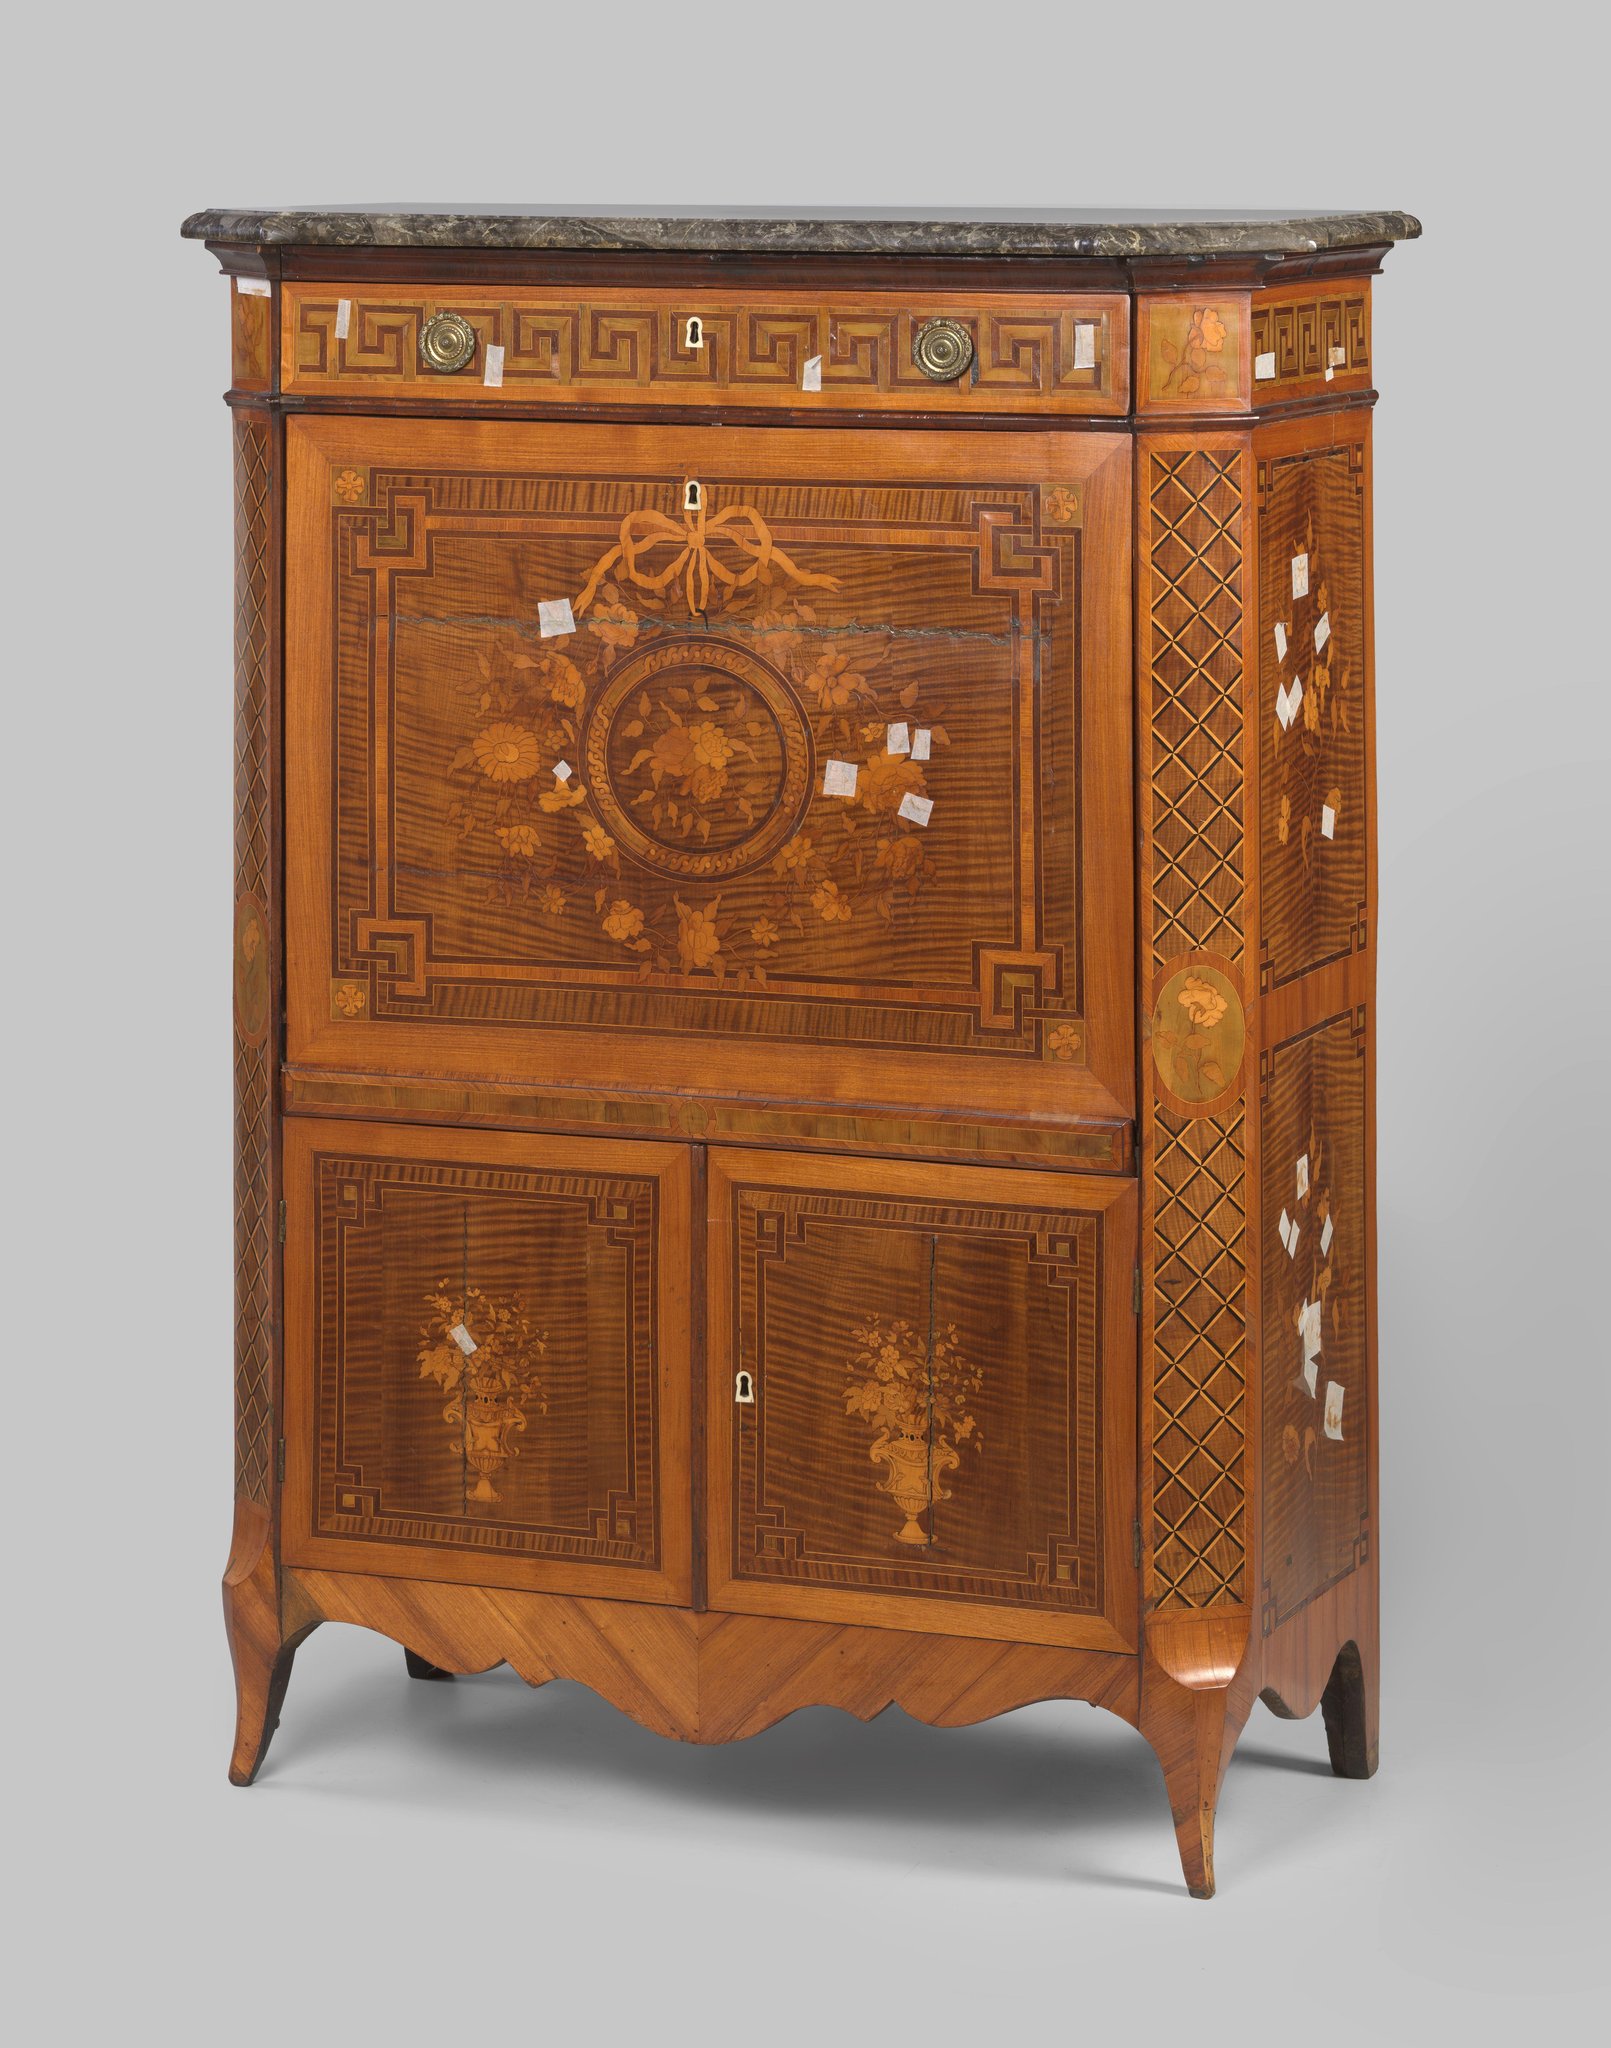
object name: furniture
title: Secretaire met marqueterieversiering: op de deuren vazen met bloemen en op de zijpanelen boeketten. Blad van grijs marmer.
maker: Anonymous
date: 1770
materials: wood, marble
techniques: marquetry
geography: northern netherlands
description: Secretaire. Oak, veneered with sycamore, tulipwood and other woods. Netherlands, c. 1770 - 1780.